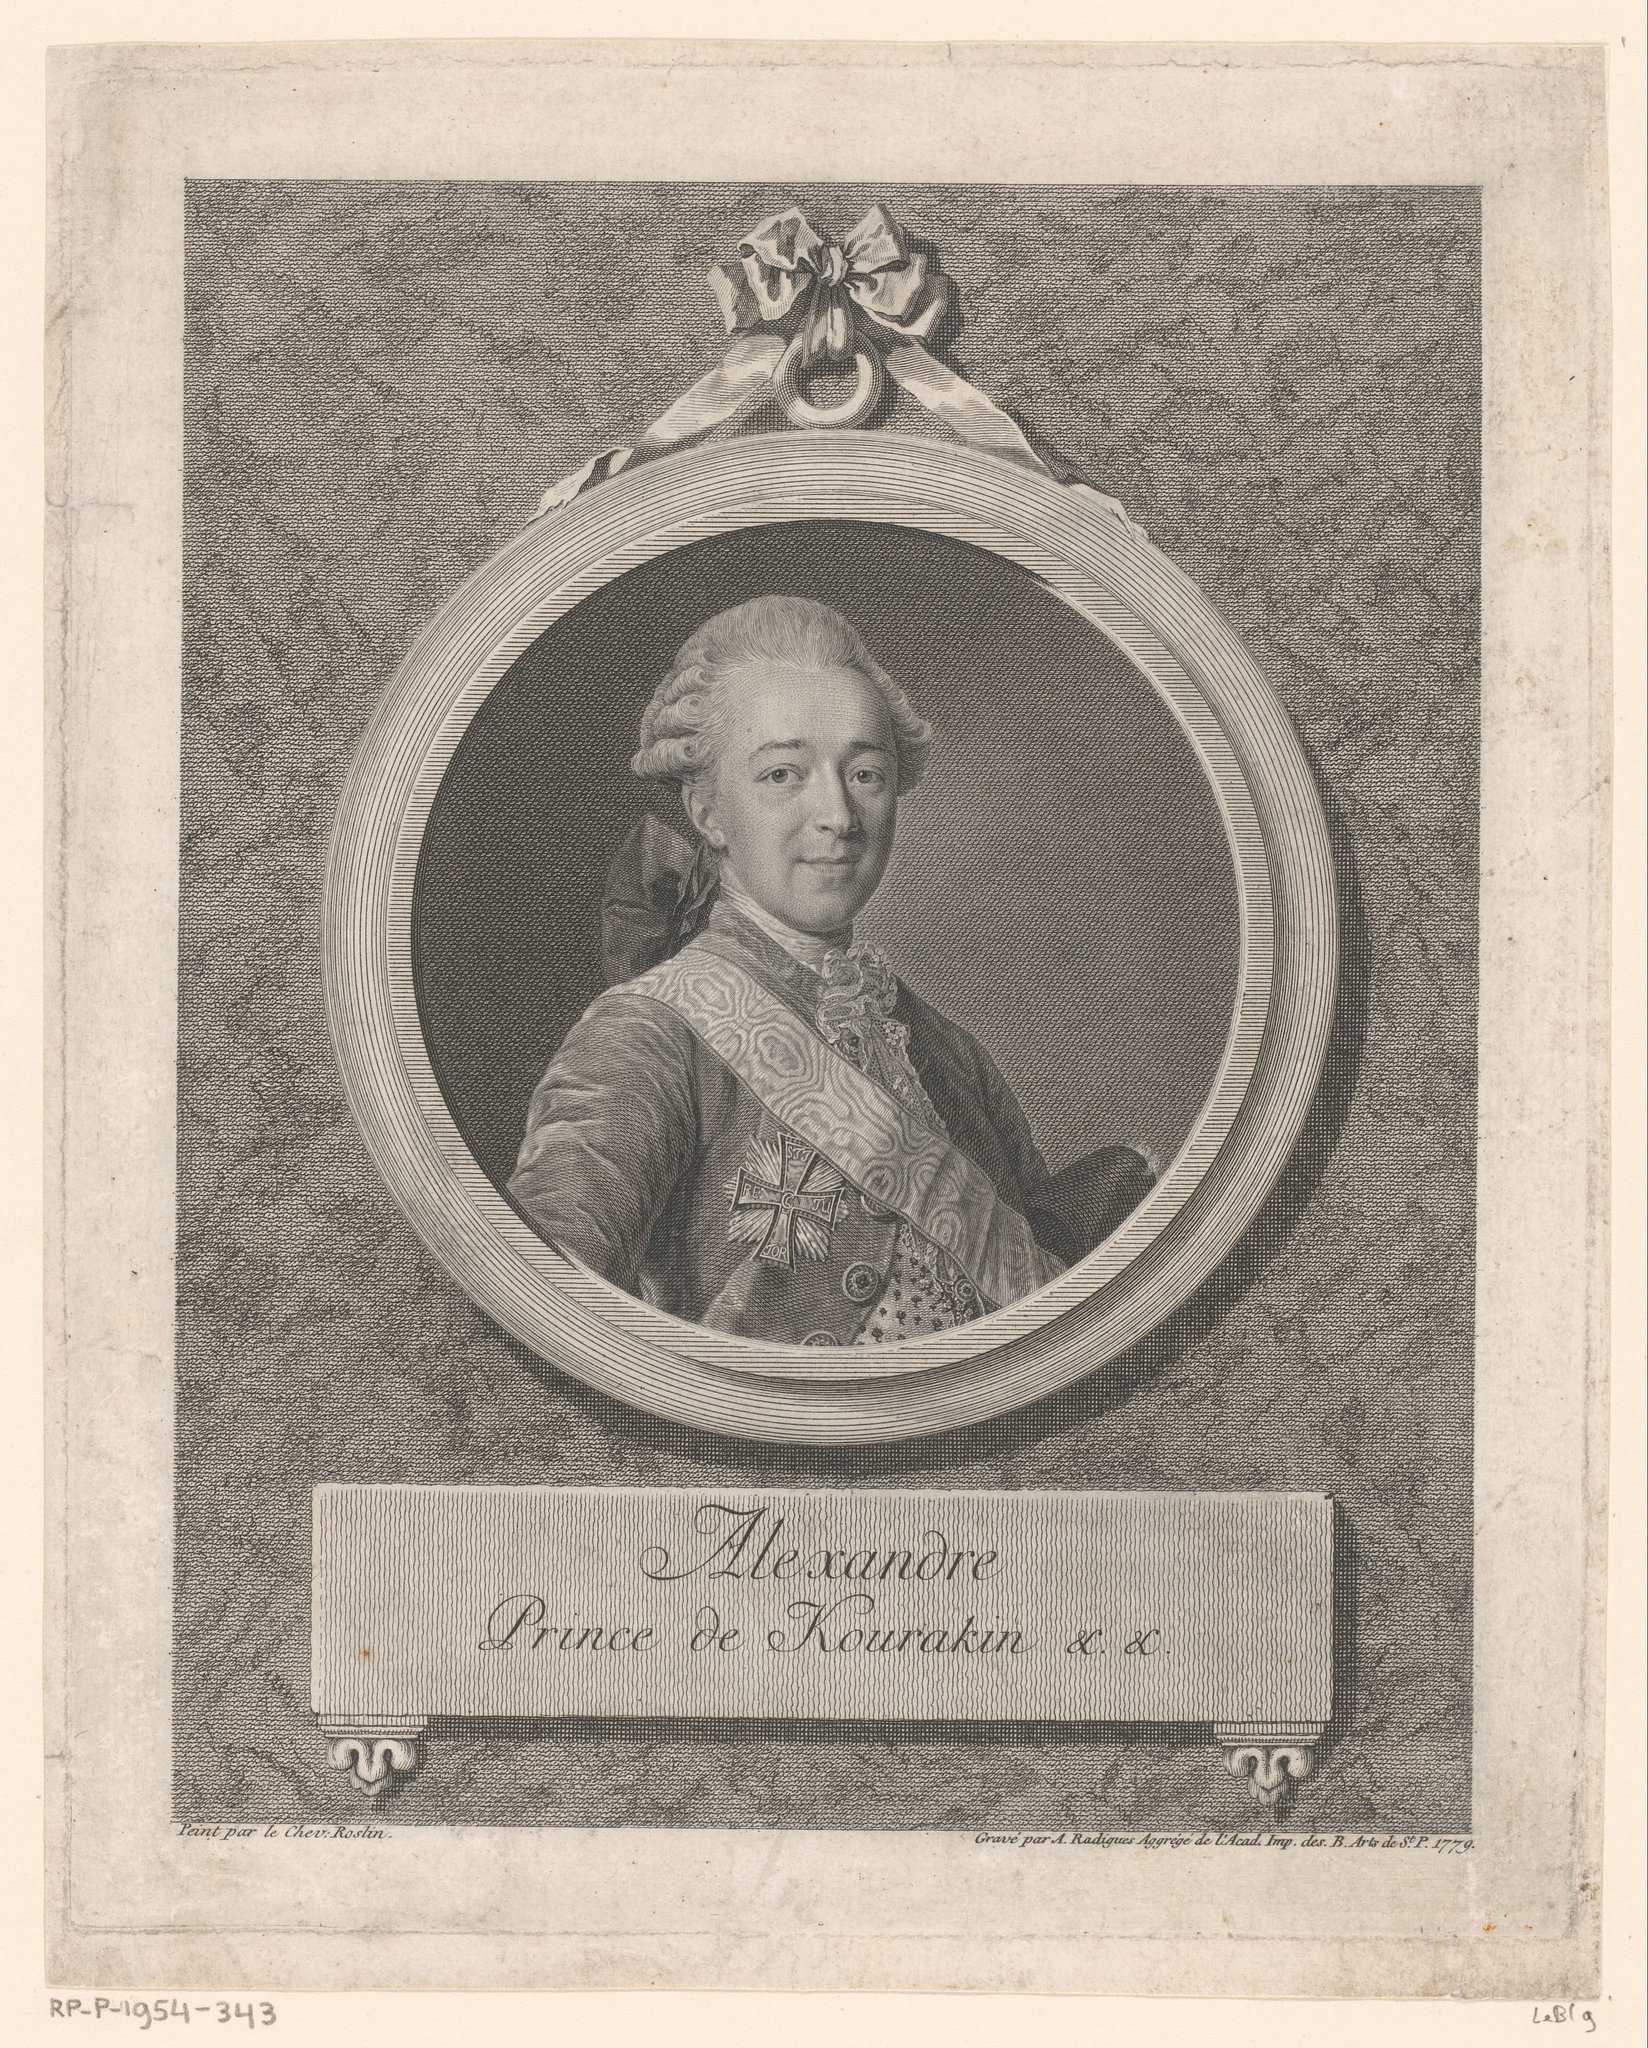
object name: print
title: Portret van Alexander Kurakin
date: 1779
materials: paper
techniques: engraving, etching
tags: prince, historical persons, diplomacy, diplomat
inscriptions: collector's mark: Lugt 2228, collector's mark: Lugt 2760